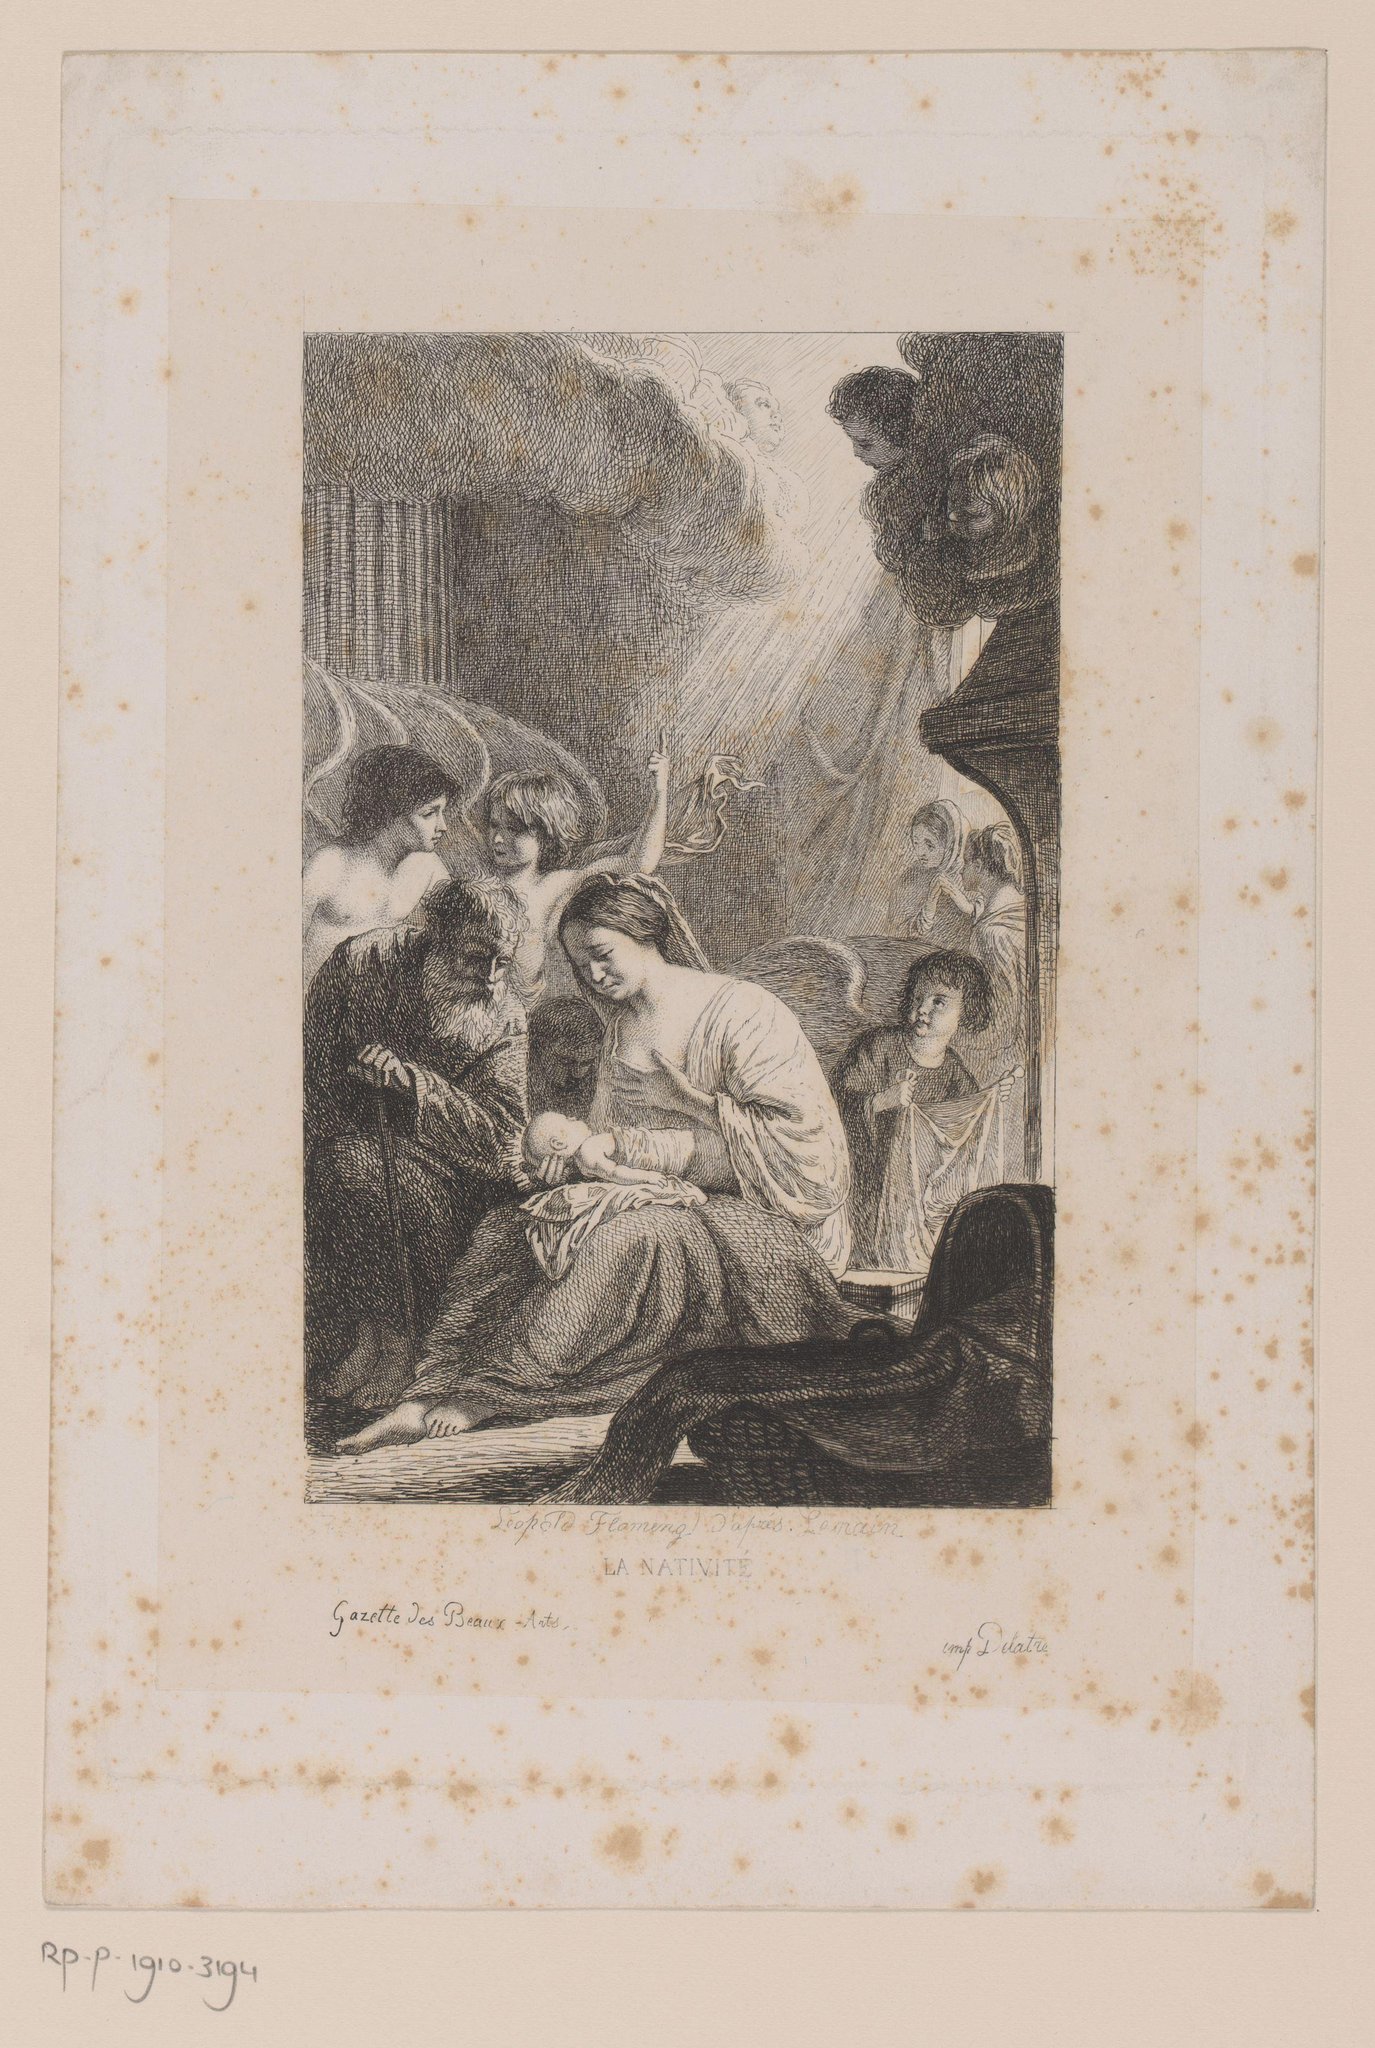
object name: print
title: La nativité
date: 1860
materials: paper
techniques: etching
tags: mary, joseph and the new-born christ (nativity)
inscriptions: collector's mark: Lugt 2228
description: Prent uit: Gazette des beaux-arts (1860), dl. 4, p. 327.